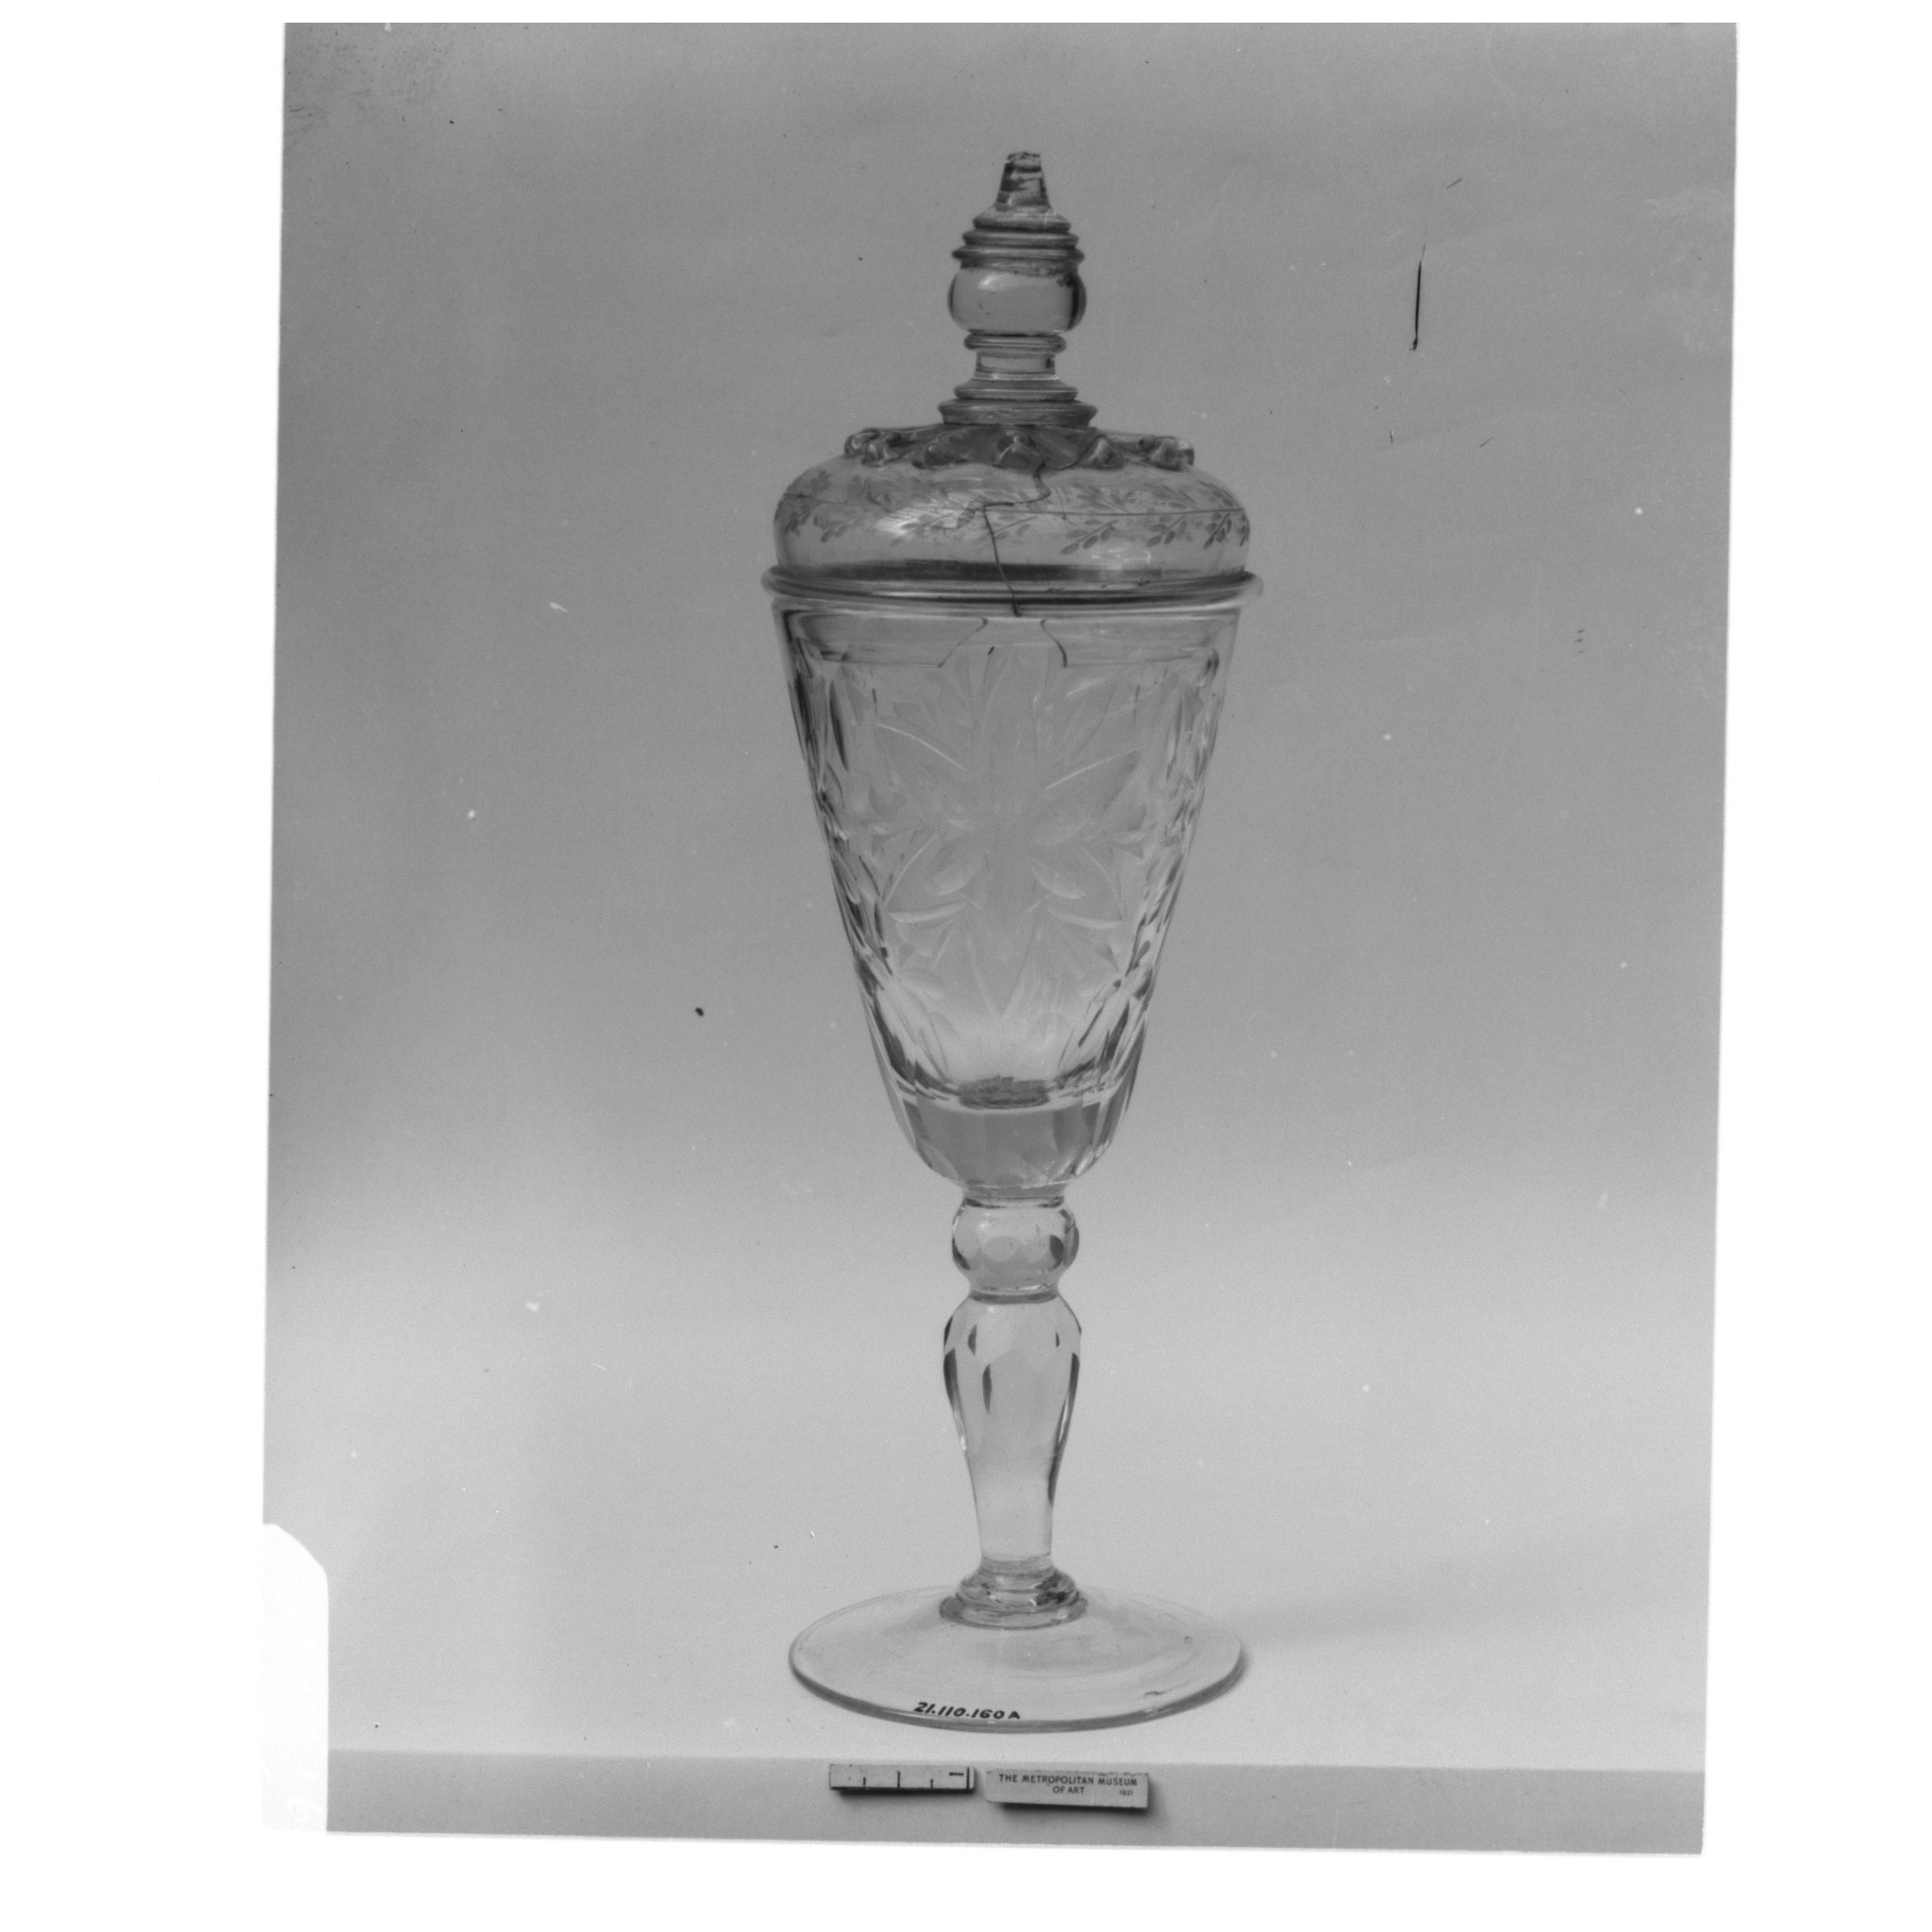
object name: wineglass with cover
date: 1801-1900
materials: glass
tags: flowers